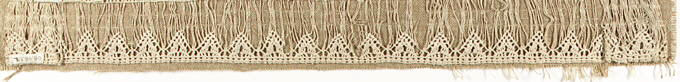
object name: edging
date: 1501-1600